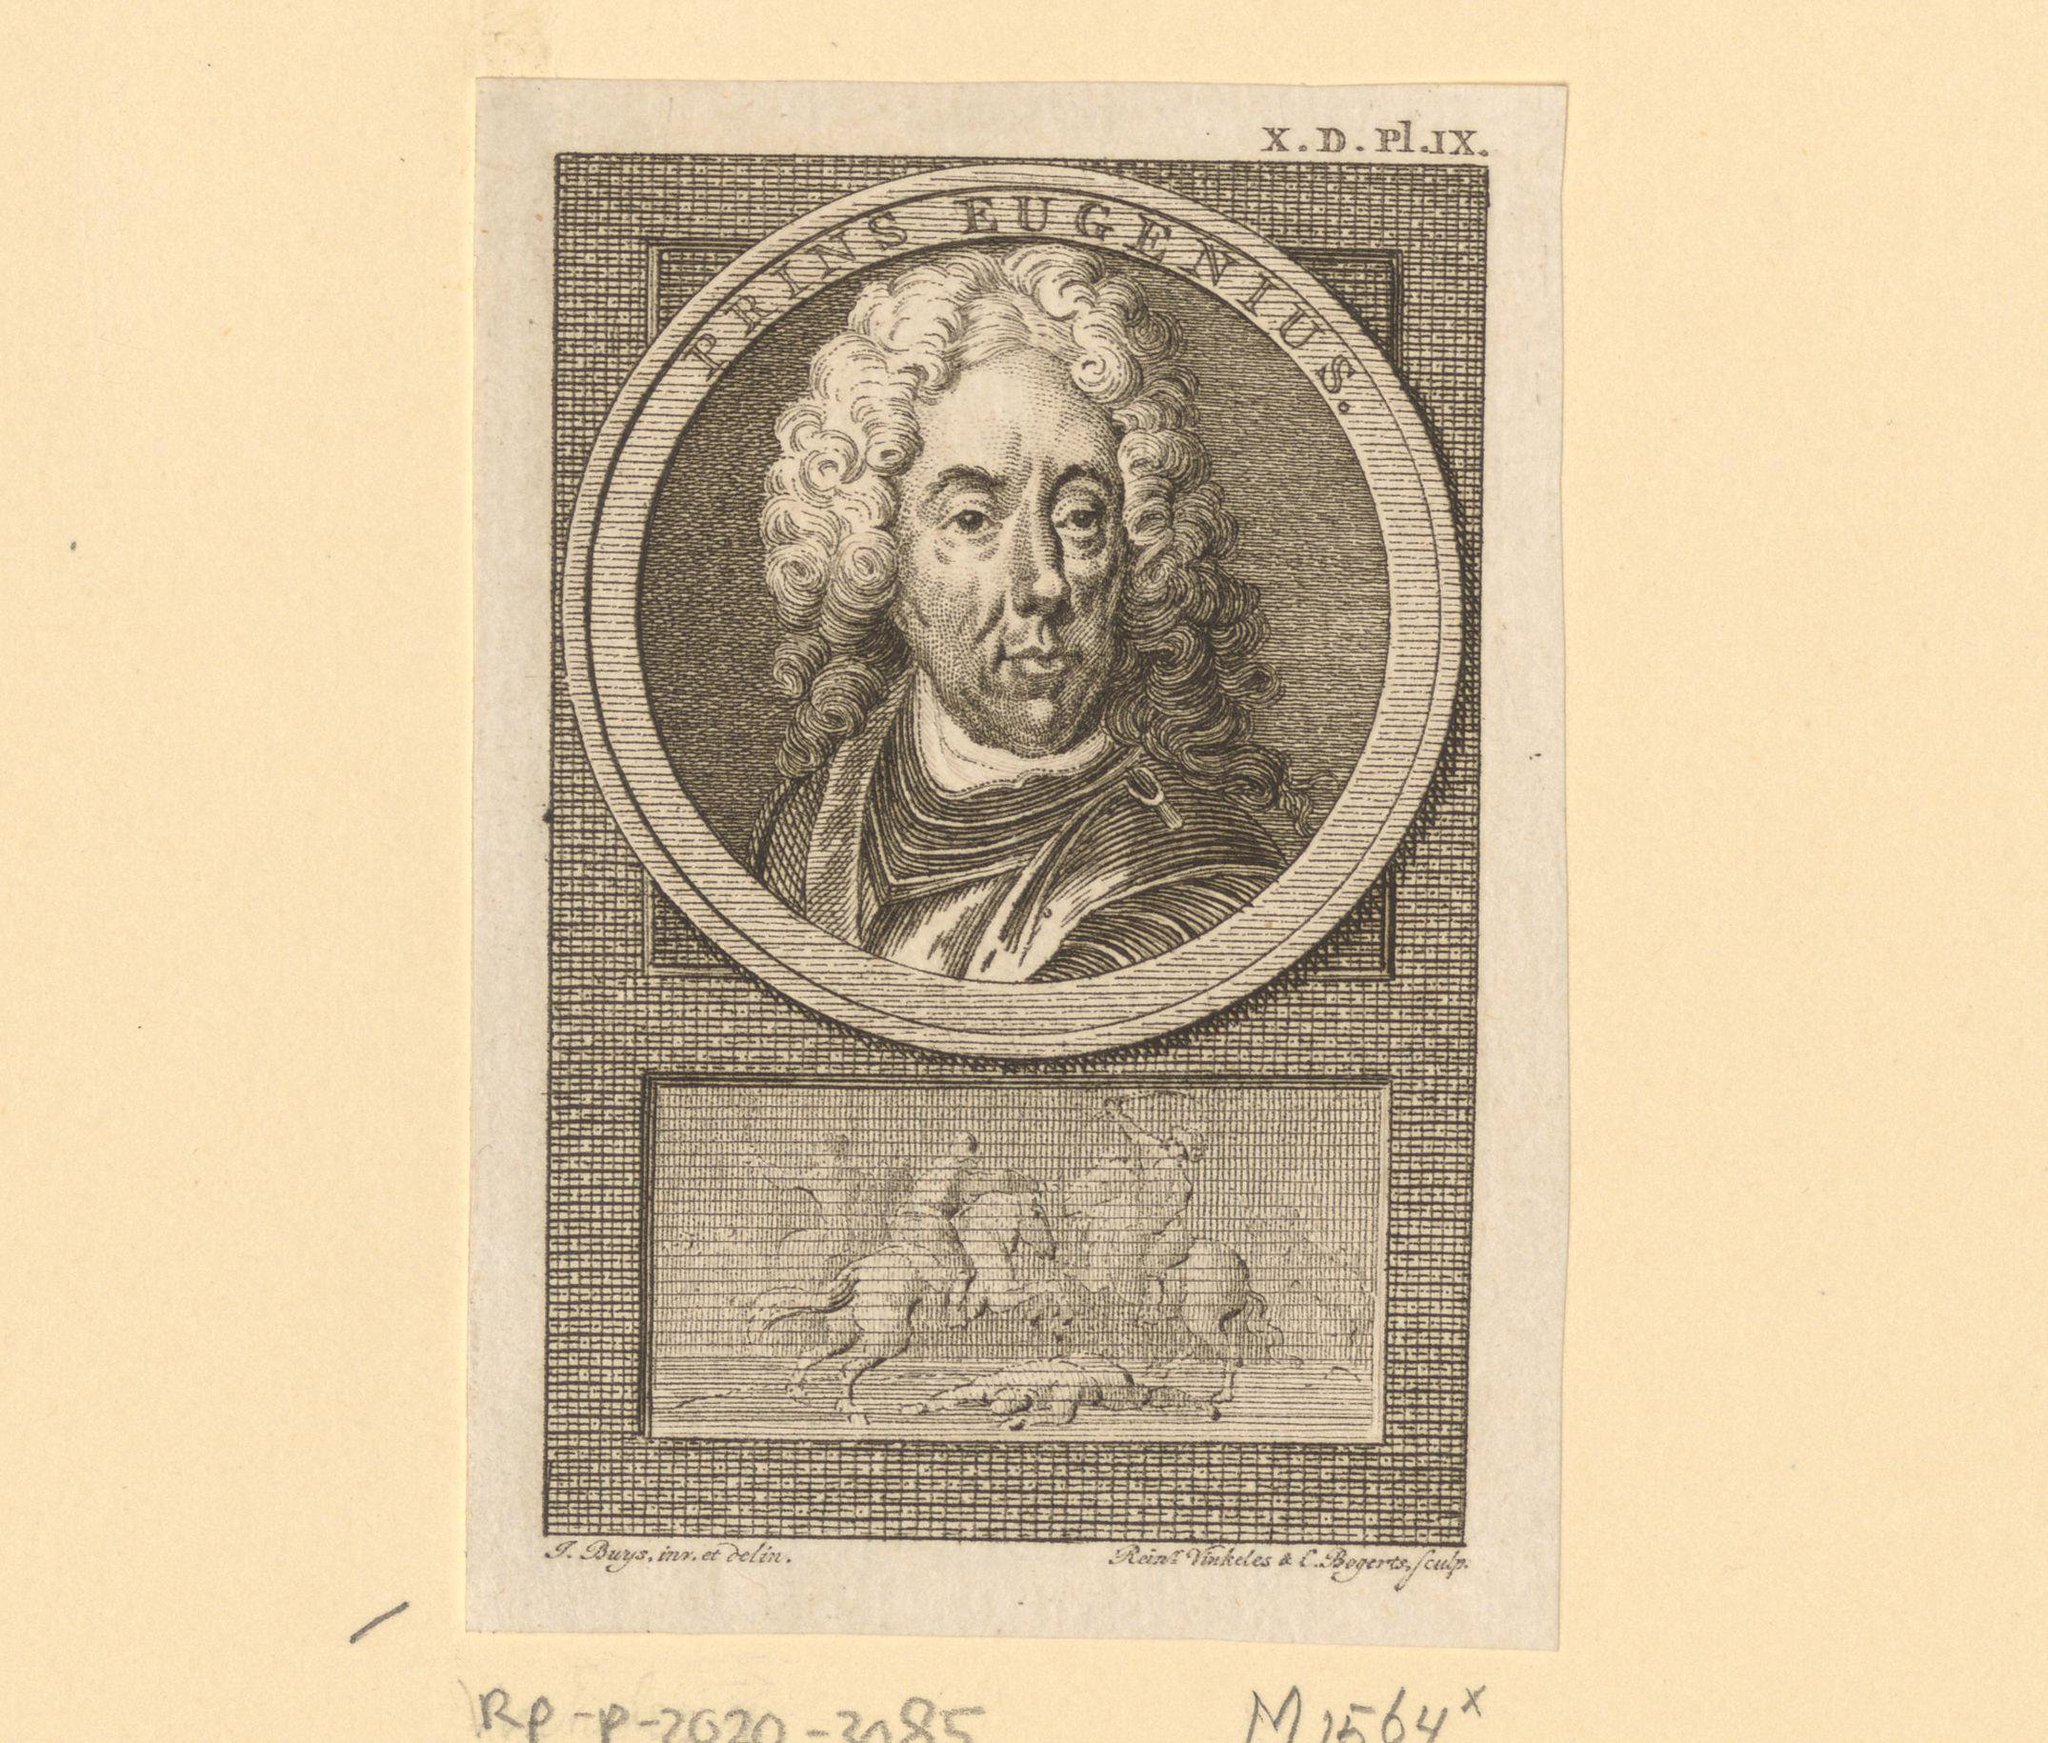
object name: book illustration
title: Portret van Eugenius van Savoye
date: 1788-1790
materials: paper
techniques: etching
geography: amsterdam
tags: paris, vienna, eugenius van savoye, historical persons, battle (+ cavalry, horsemen)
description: Prent waarschijnlijk uit: Kok, Jacobus. Geschiedenissen der Vereenigde Nederlanden: Voor de vaderlandsche jeugd (...). Amsterdam: Johannes Allart, tussen 1788-1790, dl. 10.